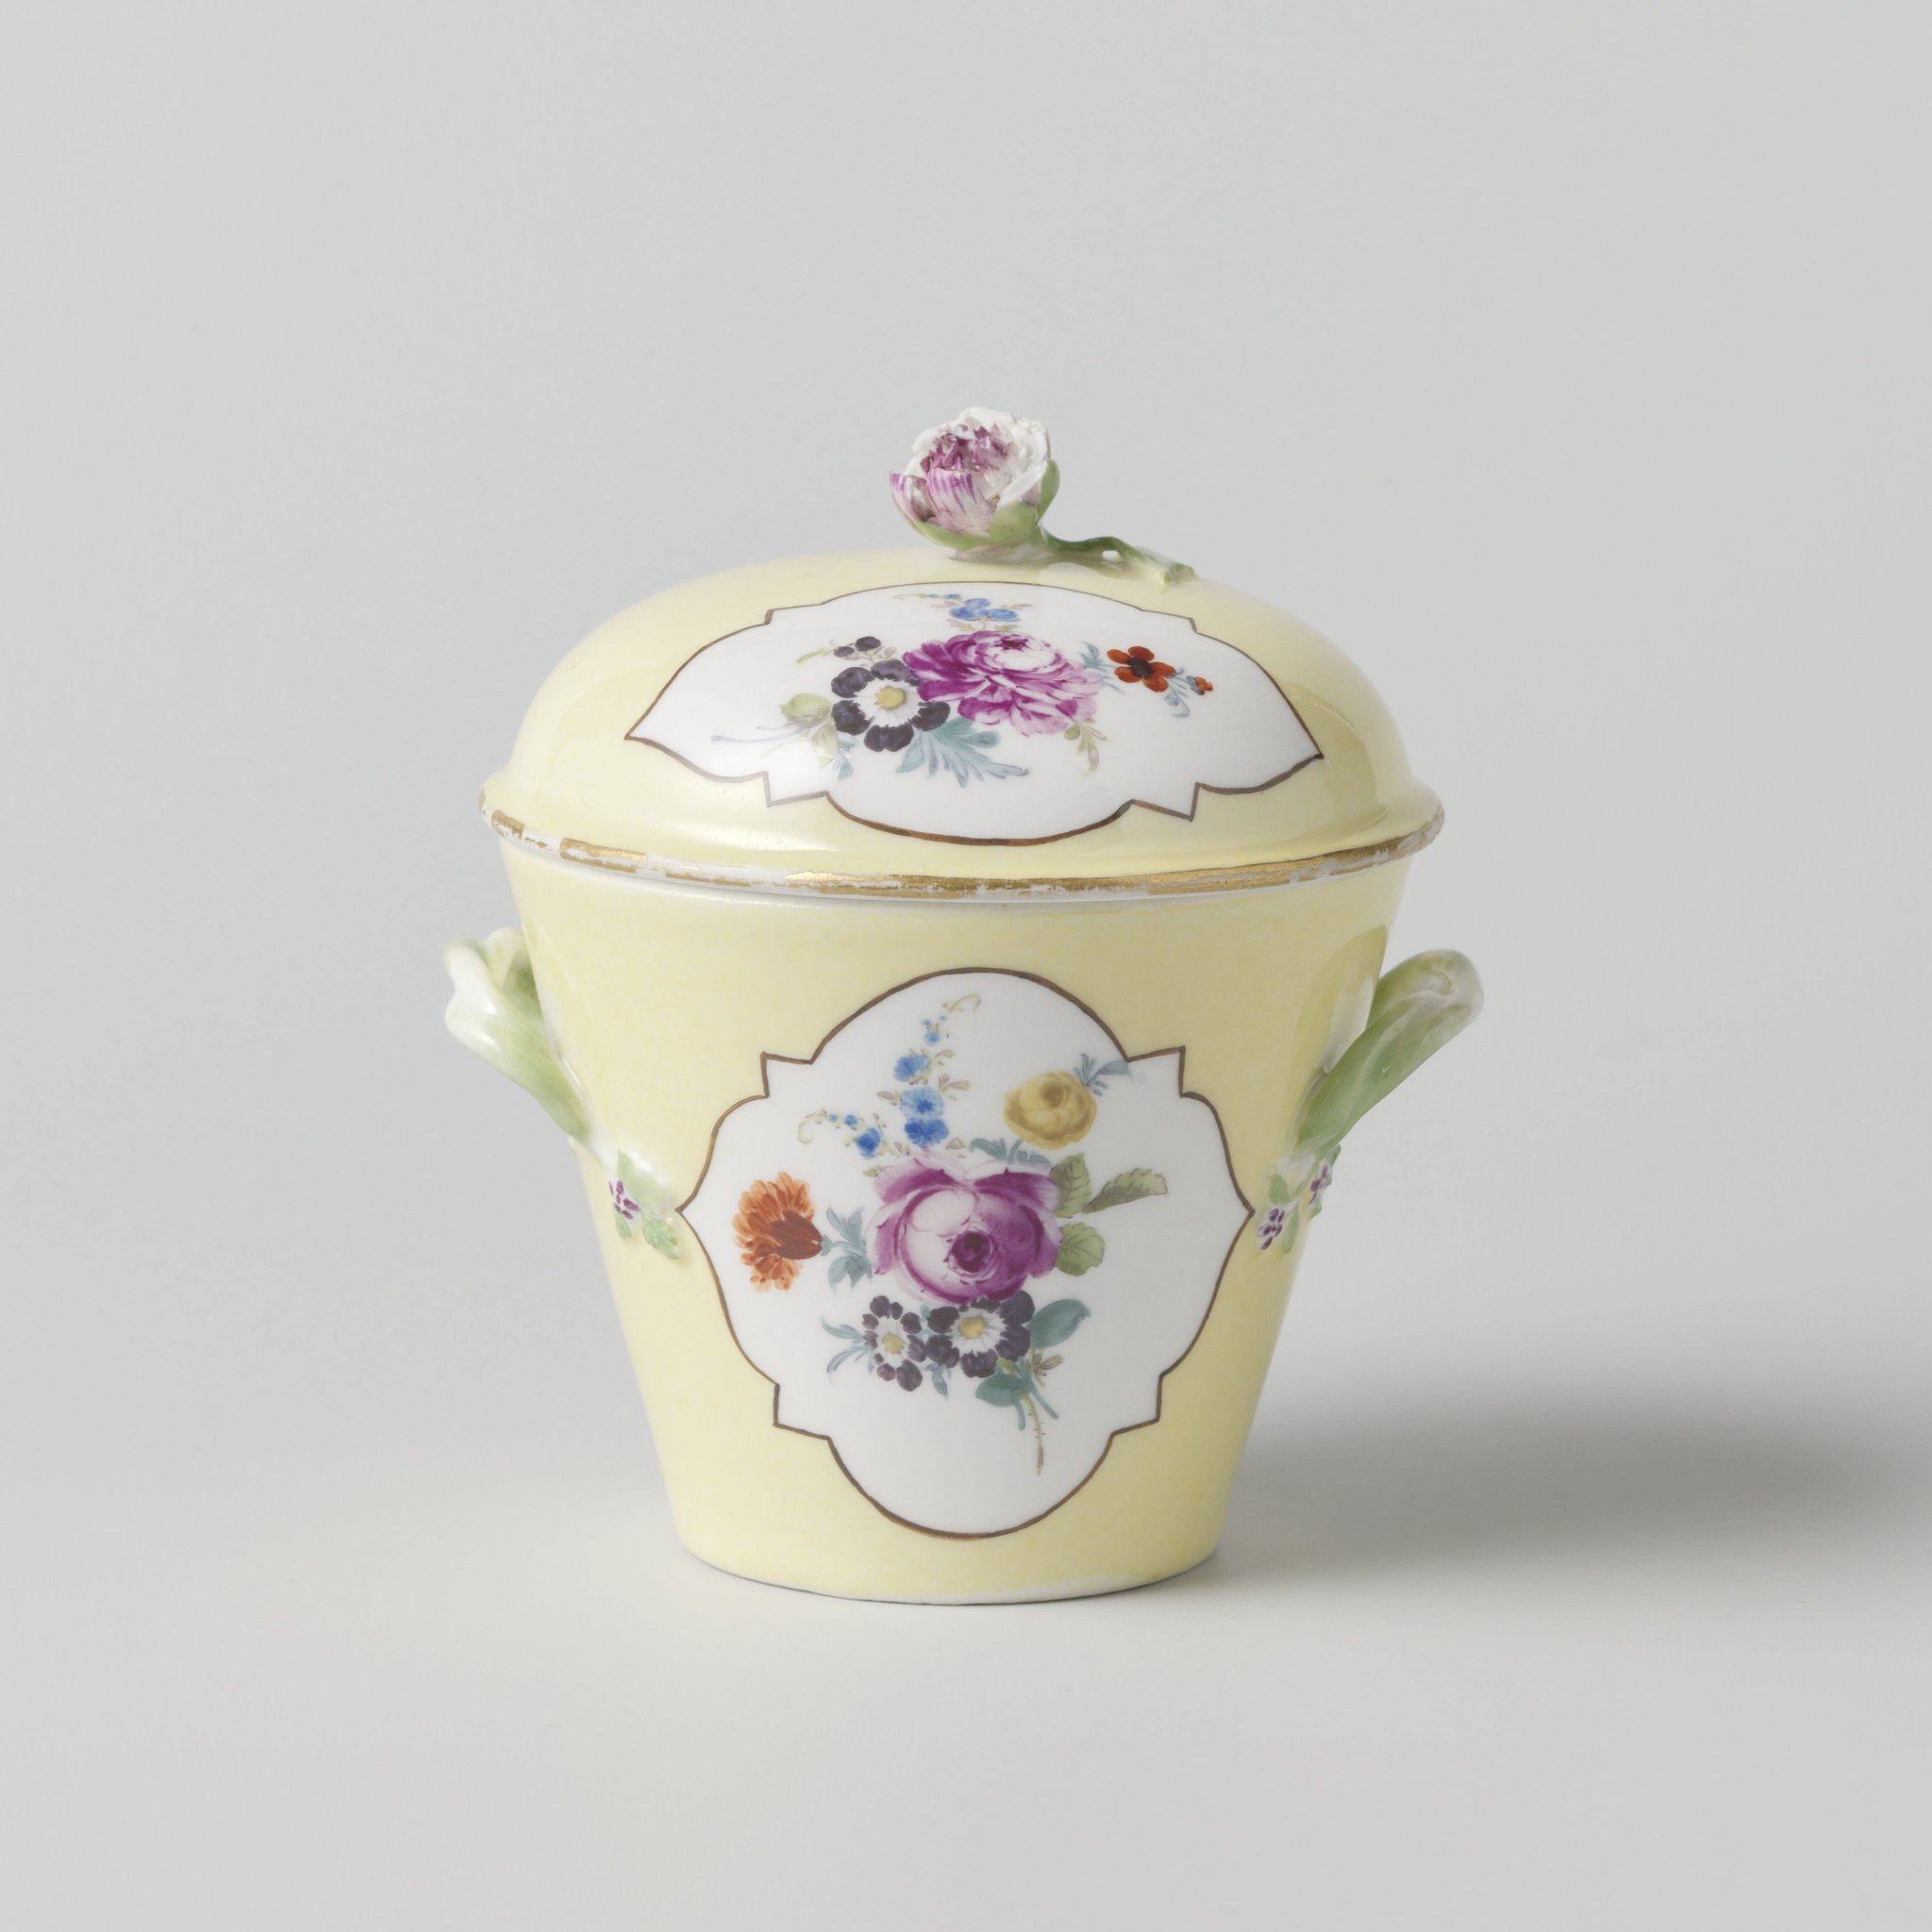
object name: lid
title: Deksel van suikerpot, veelkleurig beschilderd met Deutsche Blumen in uitgespaarde vierpassen in een gele fond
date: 1765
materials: porcelain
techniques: painted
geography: meissen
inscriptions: factory mark, mold mark: ‘32’, mark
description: Deksel van beschilderd porselein. Het deksel heeft een knop in de vorm van een bloem,en is bedekt met een gele fond met uitgespaarde vierpassen waarin Deutsche Blumen.